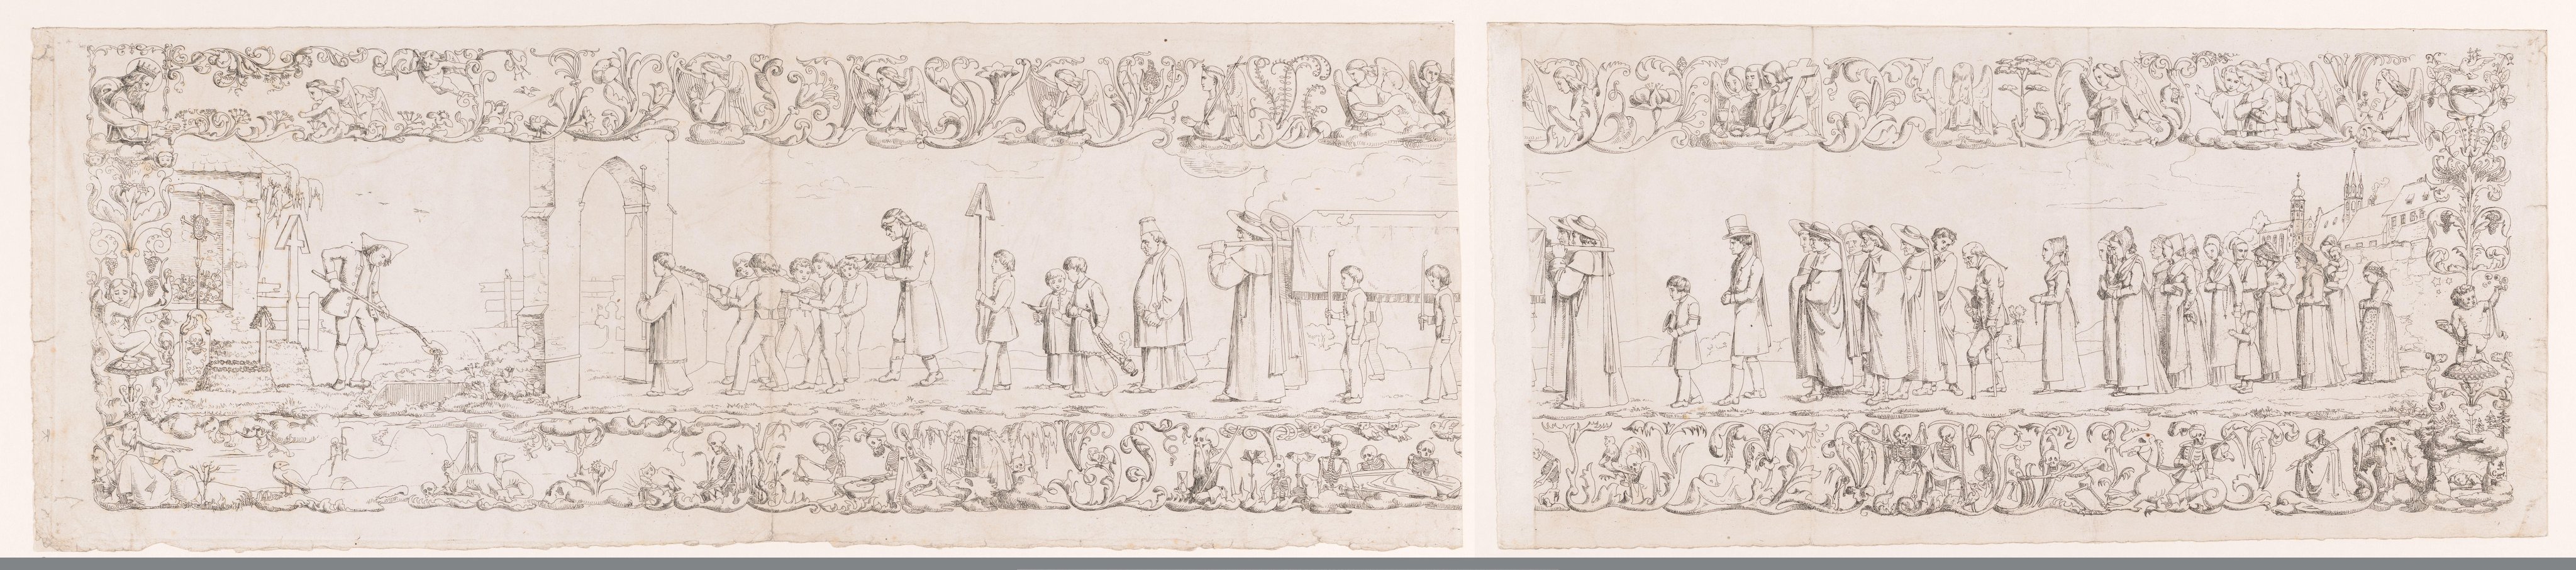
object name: print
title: Begrafenisstoet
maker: karl sandhaas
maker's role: print maker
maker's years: 1801-1859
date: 1825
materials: paper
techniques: etching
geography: germany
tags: symbols of death, cortege, funeral procession, angels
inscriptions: collector's mark: Lugt 2228, collector's mark: Lugt 2760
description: Begrafenisstoet, leidend naar een graf dat wordt gegraven op een kerkhof links. Vooraan de stoet zingende jongens, onder een poort doorlopend; daarachter een jongen met een crucifix, twee misdienaars en een priester. Achter de priester de dragers van de kist. Achter de kist lopen de familieleden: eerst de heren, daarachter de dames. Het geheel in een ornamentrand die bestaat uit engelen, symbolen van de dood en bladranken.